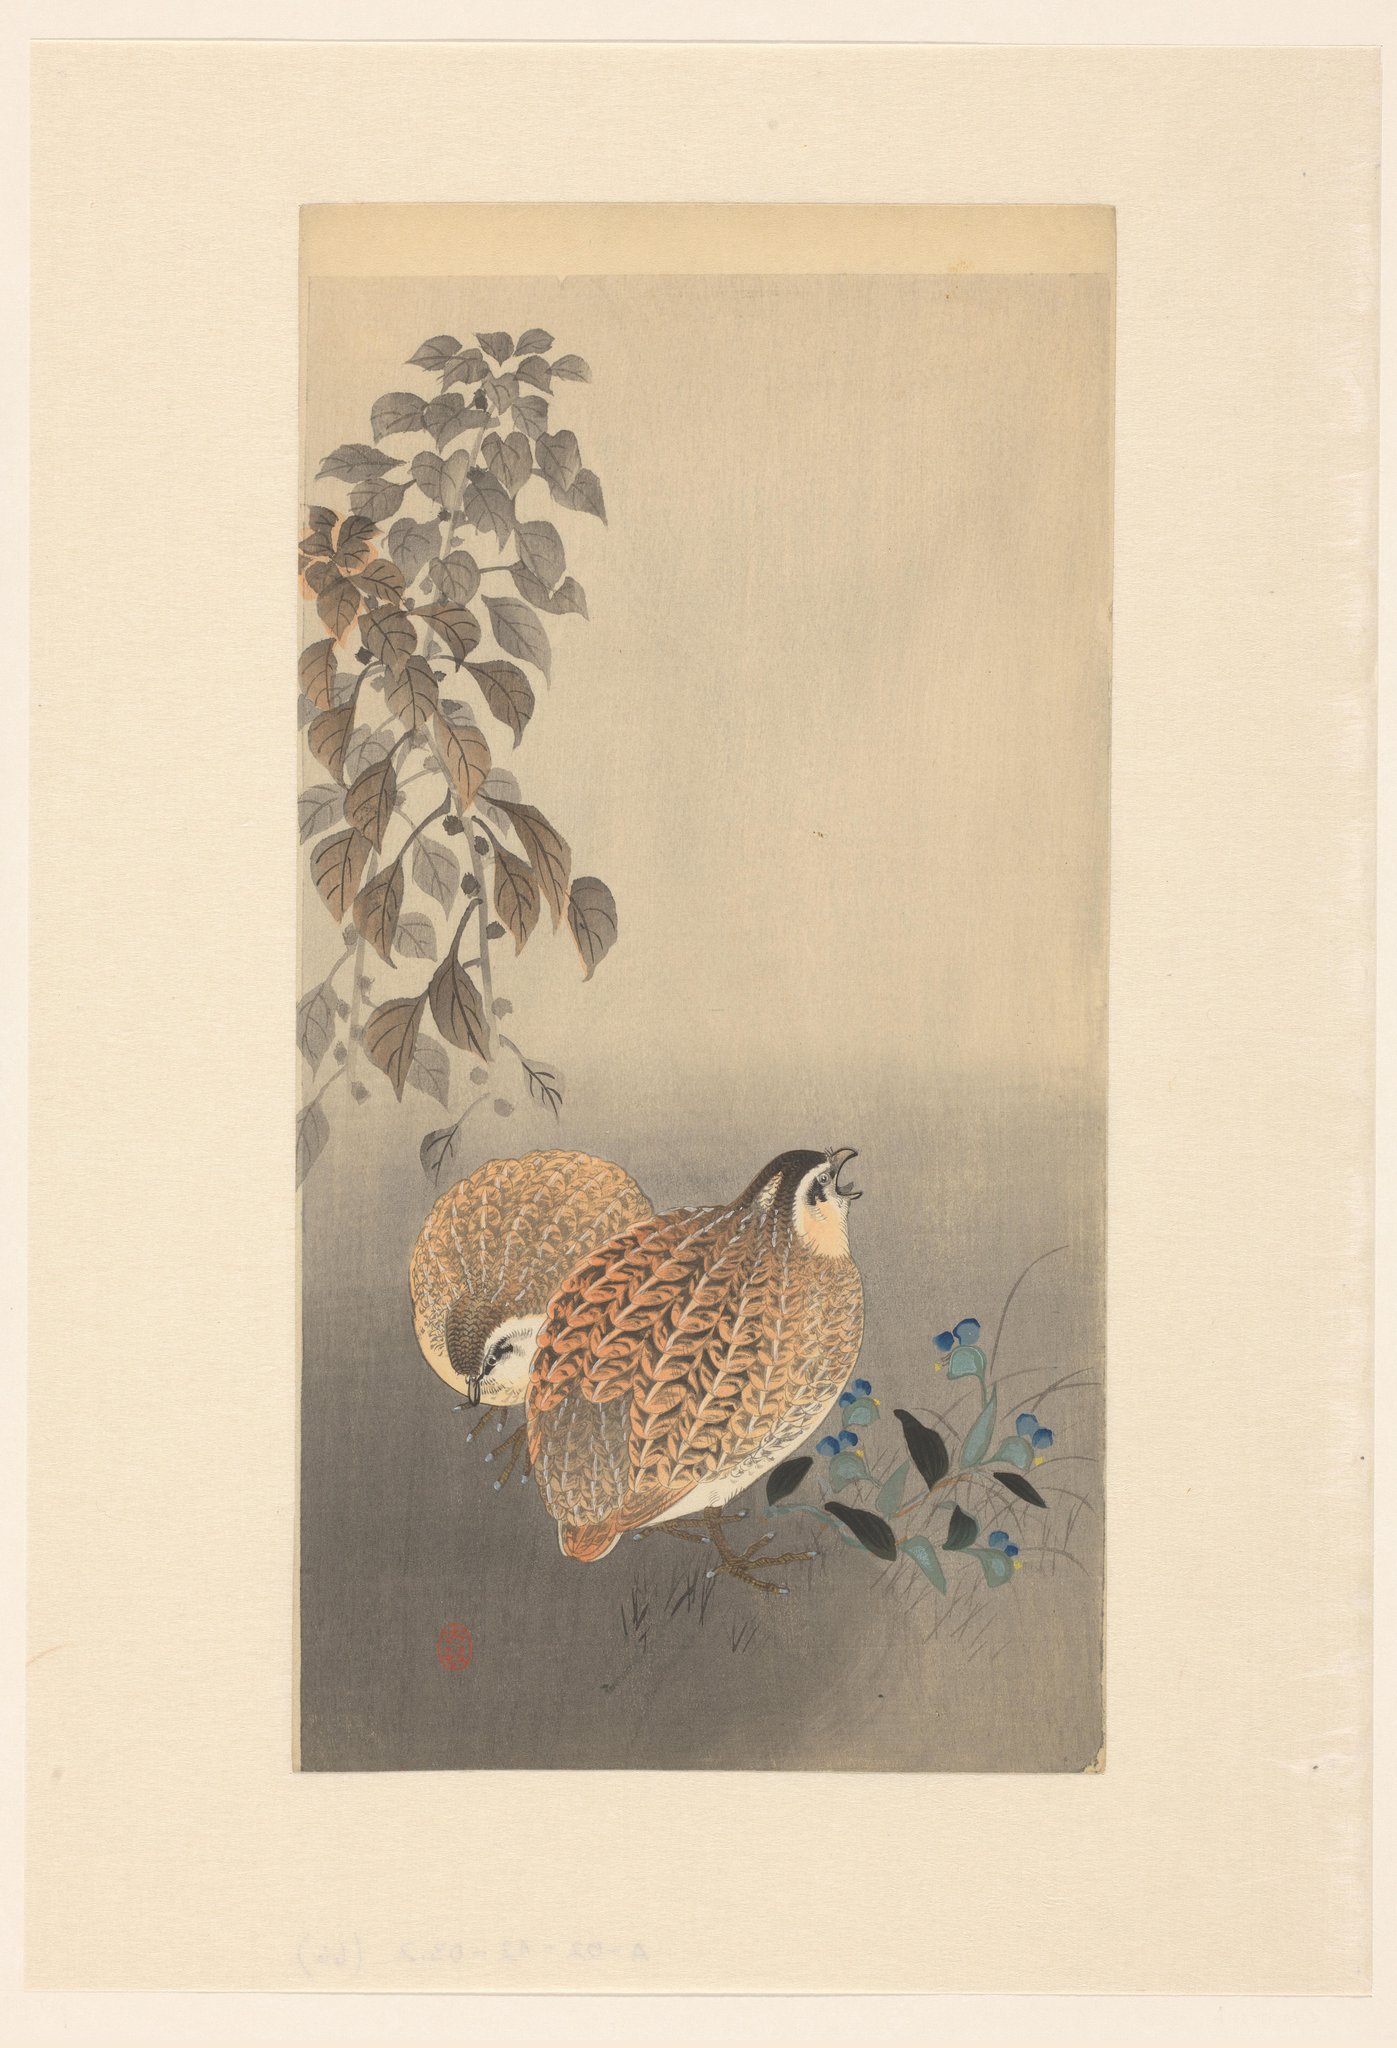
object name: print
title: Twee kwartels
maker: ohara koson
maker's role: print maker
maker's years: 1877-1945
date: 1900-1930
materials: paper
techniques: woodcut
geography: tokyo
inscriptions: collector's mark: Lugt 2228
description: Twee kwartels in gras bij blauwe bloemen, links een struik.